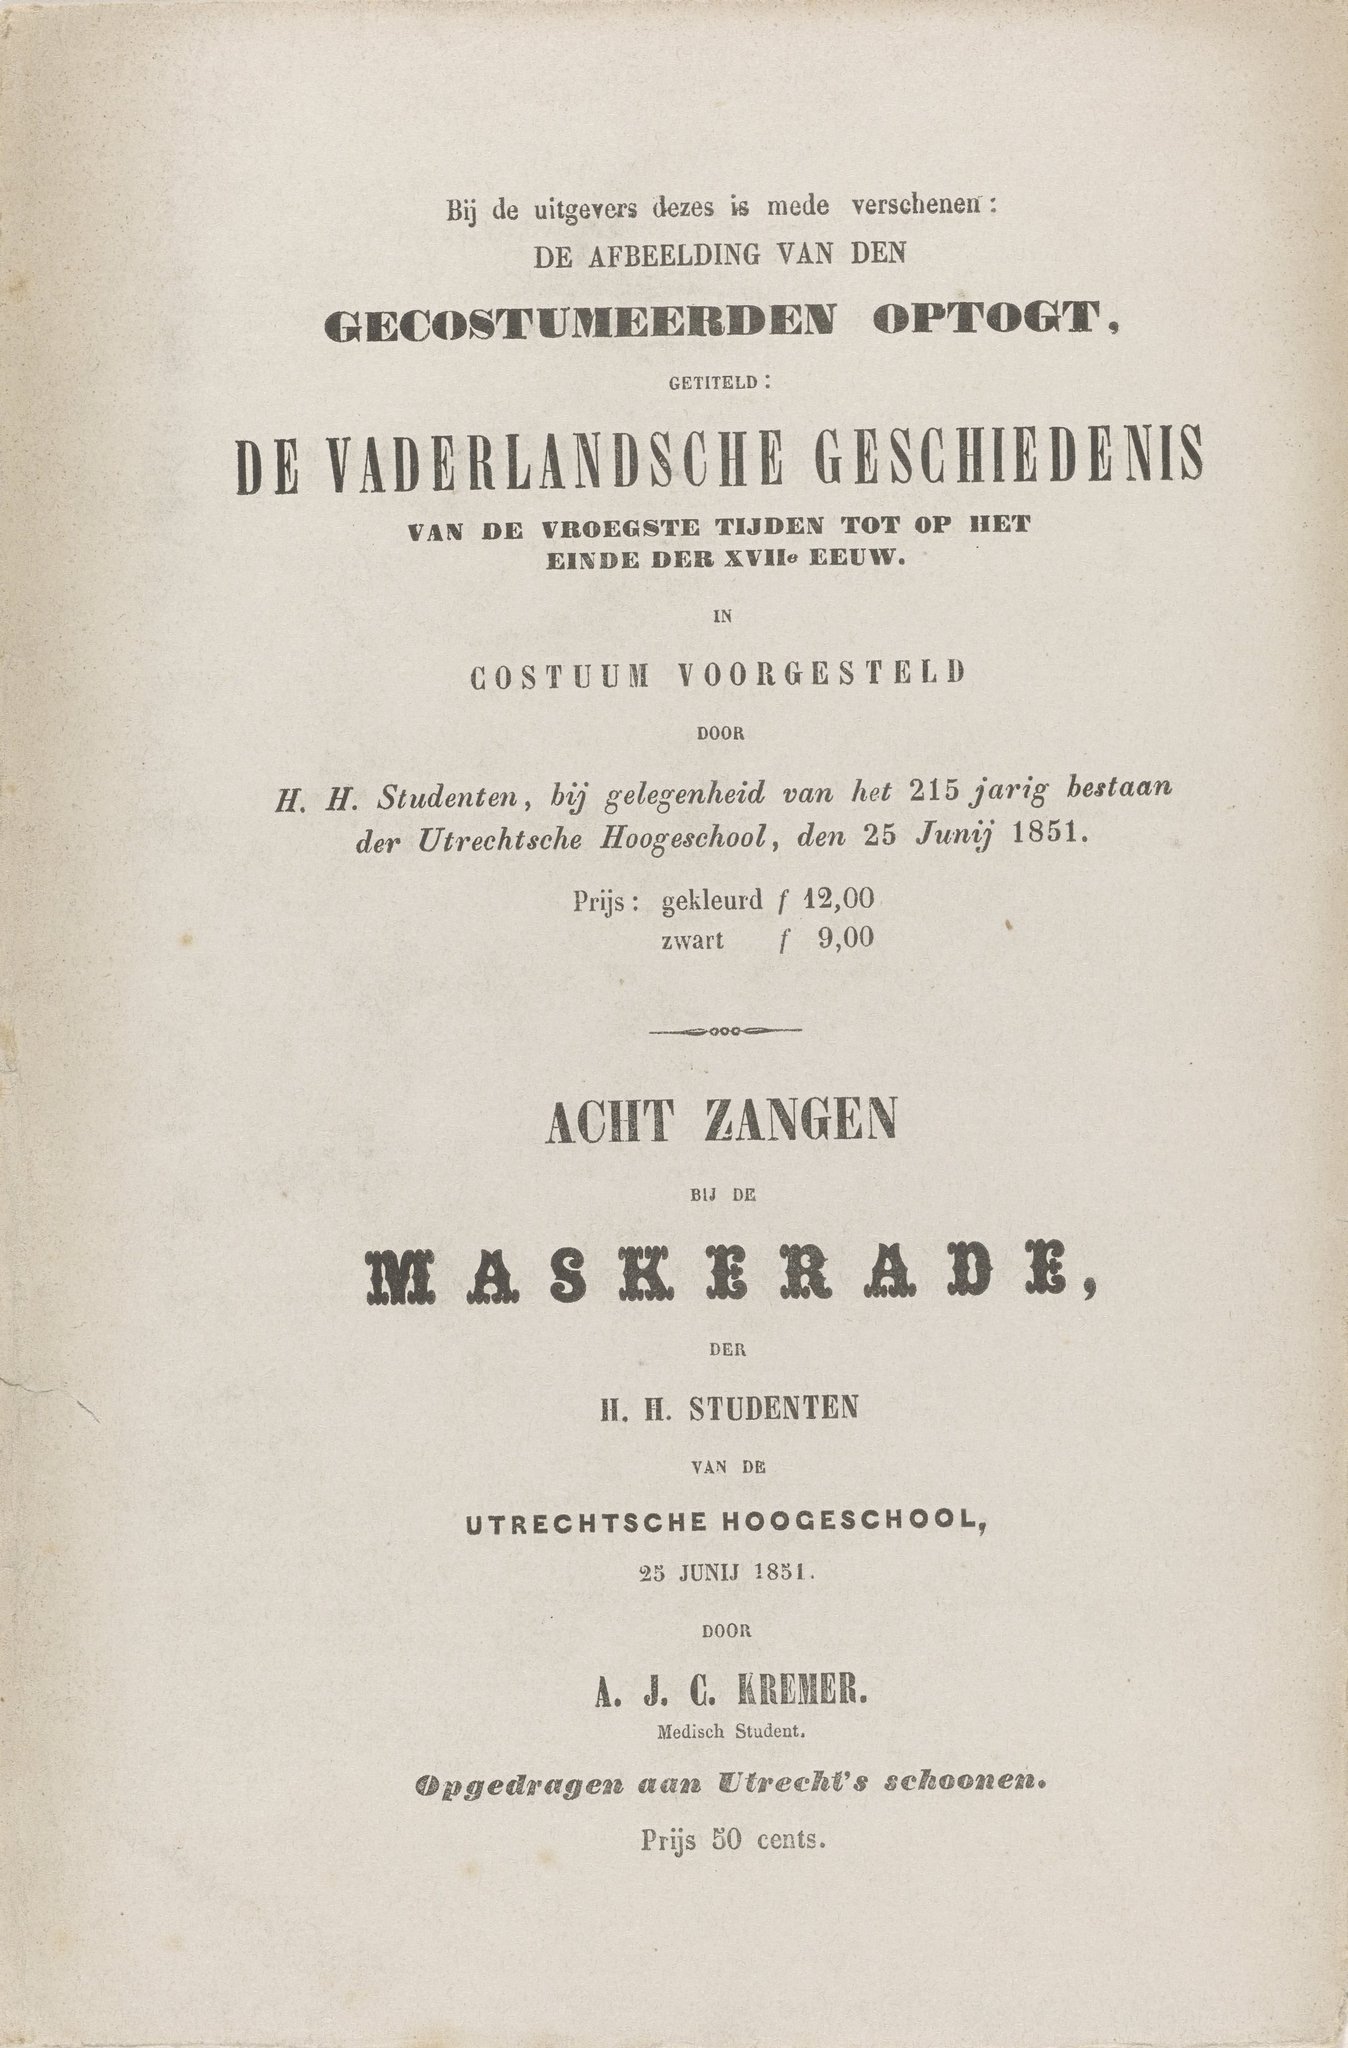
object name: uitgeversbrochure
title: Aankondiging van de prentenreeks en van acht zangen van de Utrechtse maskerade van 1851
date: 1851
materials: paper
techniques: letterpress printing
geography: utrecht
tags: students' pageant, costumes used in pageants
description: Aankondiging van het verschijnen van de acht prenten en acht zangen van de maskerade van de Utrechtse studenten, 25 juni 1851.